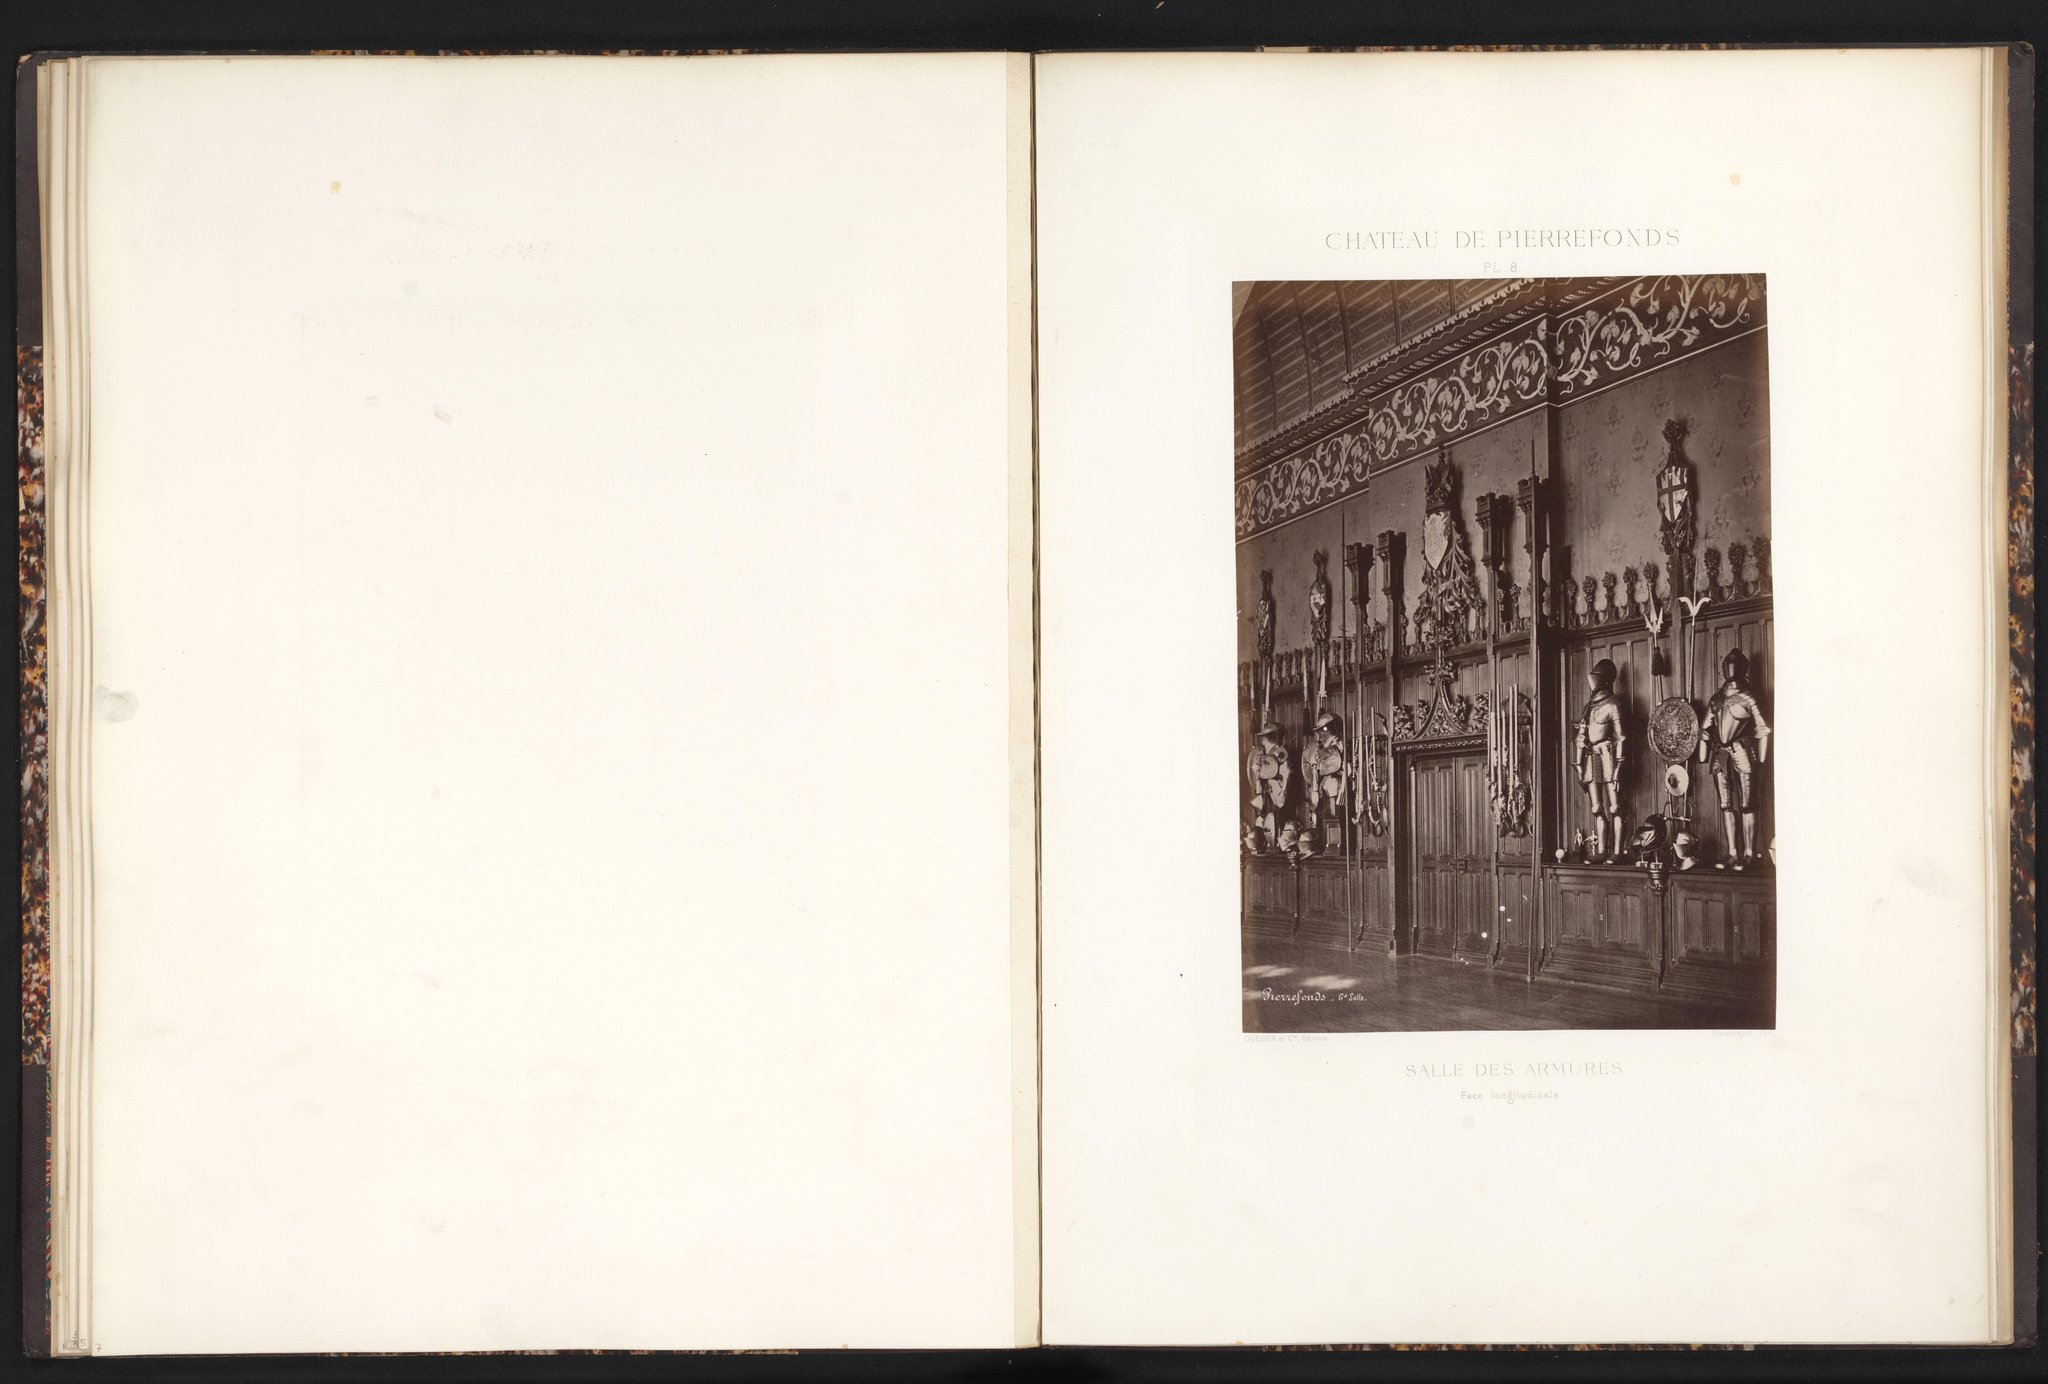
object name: photograph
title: Zaal met wapenuitrustingen in het kasteel van Pierrefonds, Frankrijk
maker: séraphin-médéric mieusement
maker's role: fotograaf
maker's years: 1840-1905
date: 1870-1875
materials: photographic support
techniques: albumen print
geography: château de pierrefonds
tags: castle - aa - civic architecture: inside, armour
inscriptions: inscription: ‘Pierrefonds - Gd Salle’, number: ‘PL. 8.’